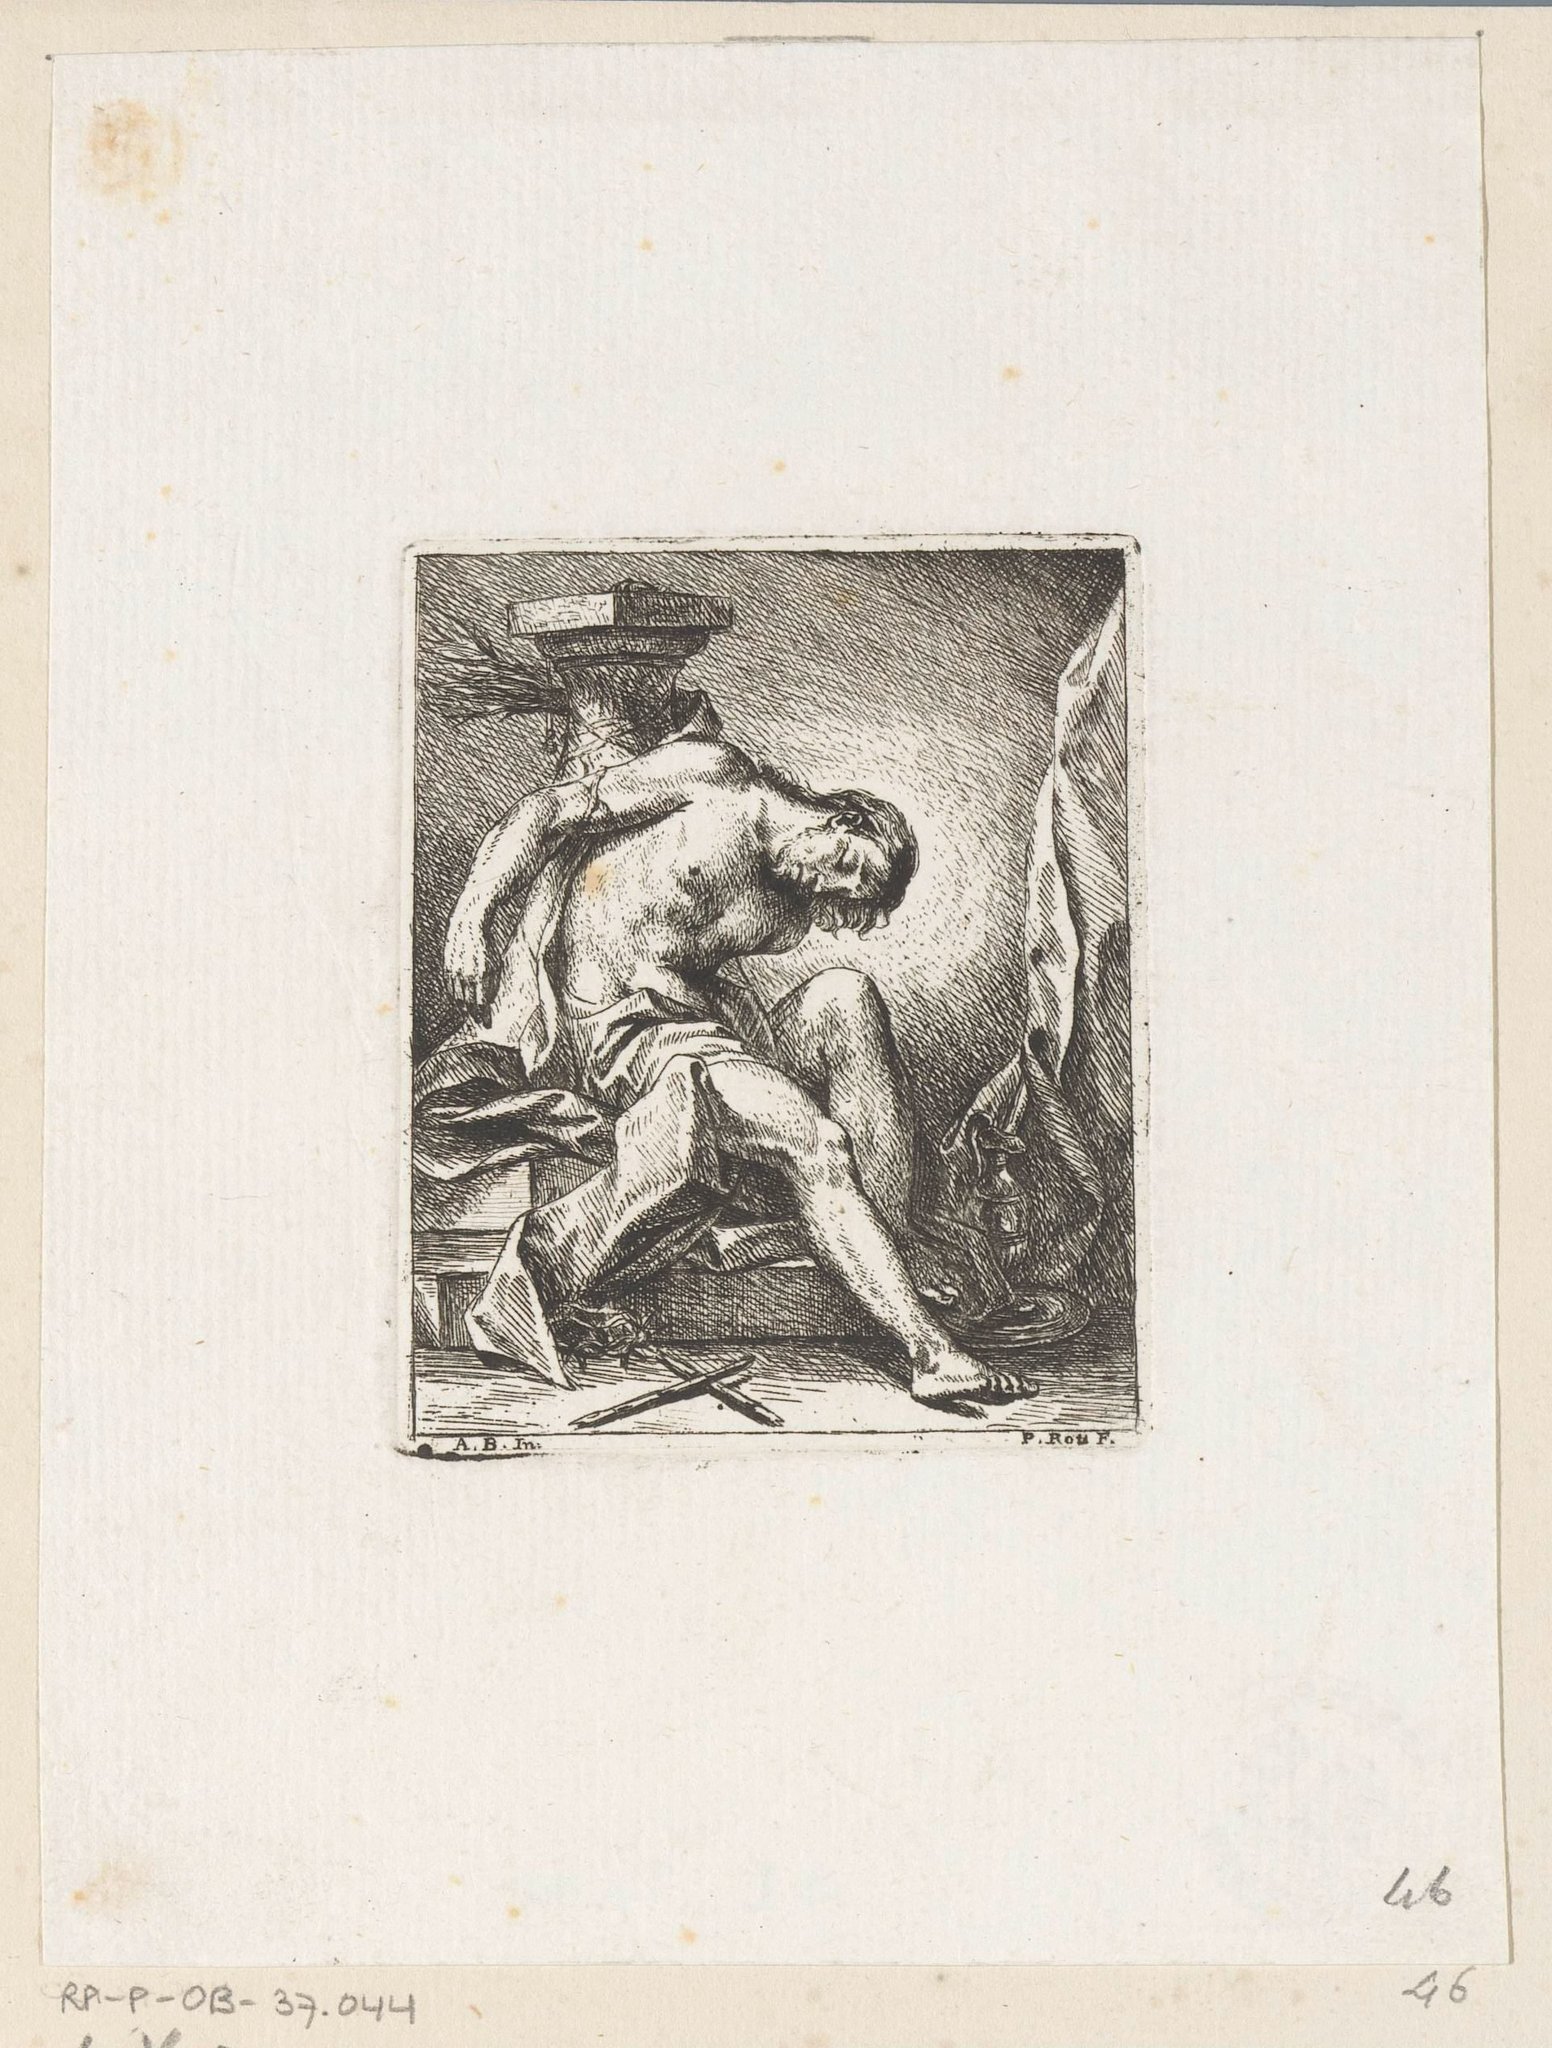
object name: print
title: Christus bij de zuil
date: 1717-1762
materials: paper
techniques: etching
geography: italy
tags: column (of the flagellation) ~ instruments of the passion, flagellation by soldiers, christ usually tied to a column (matthew 27:26; mark 15:15; john 19:1)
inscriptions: collector's mark: Lugt 240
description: Christus zit vastgebonden aan een zuil. Op de grond ligt zijn doornenkroon.